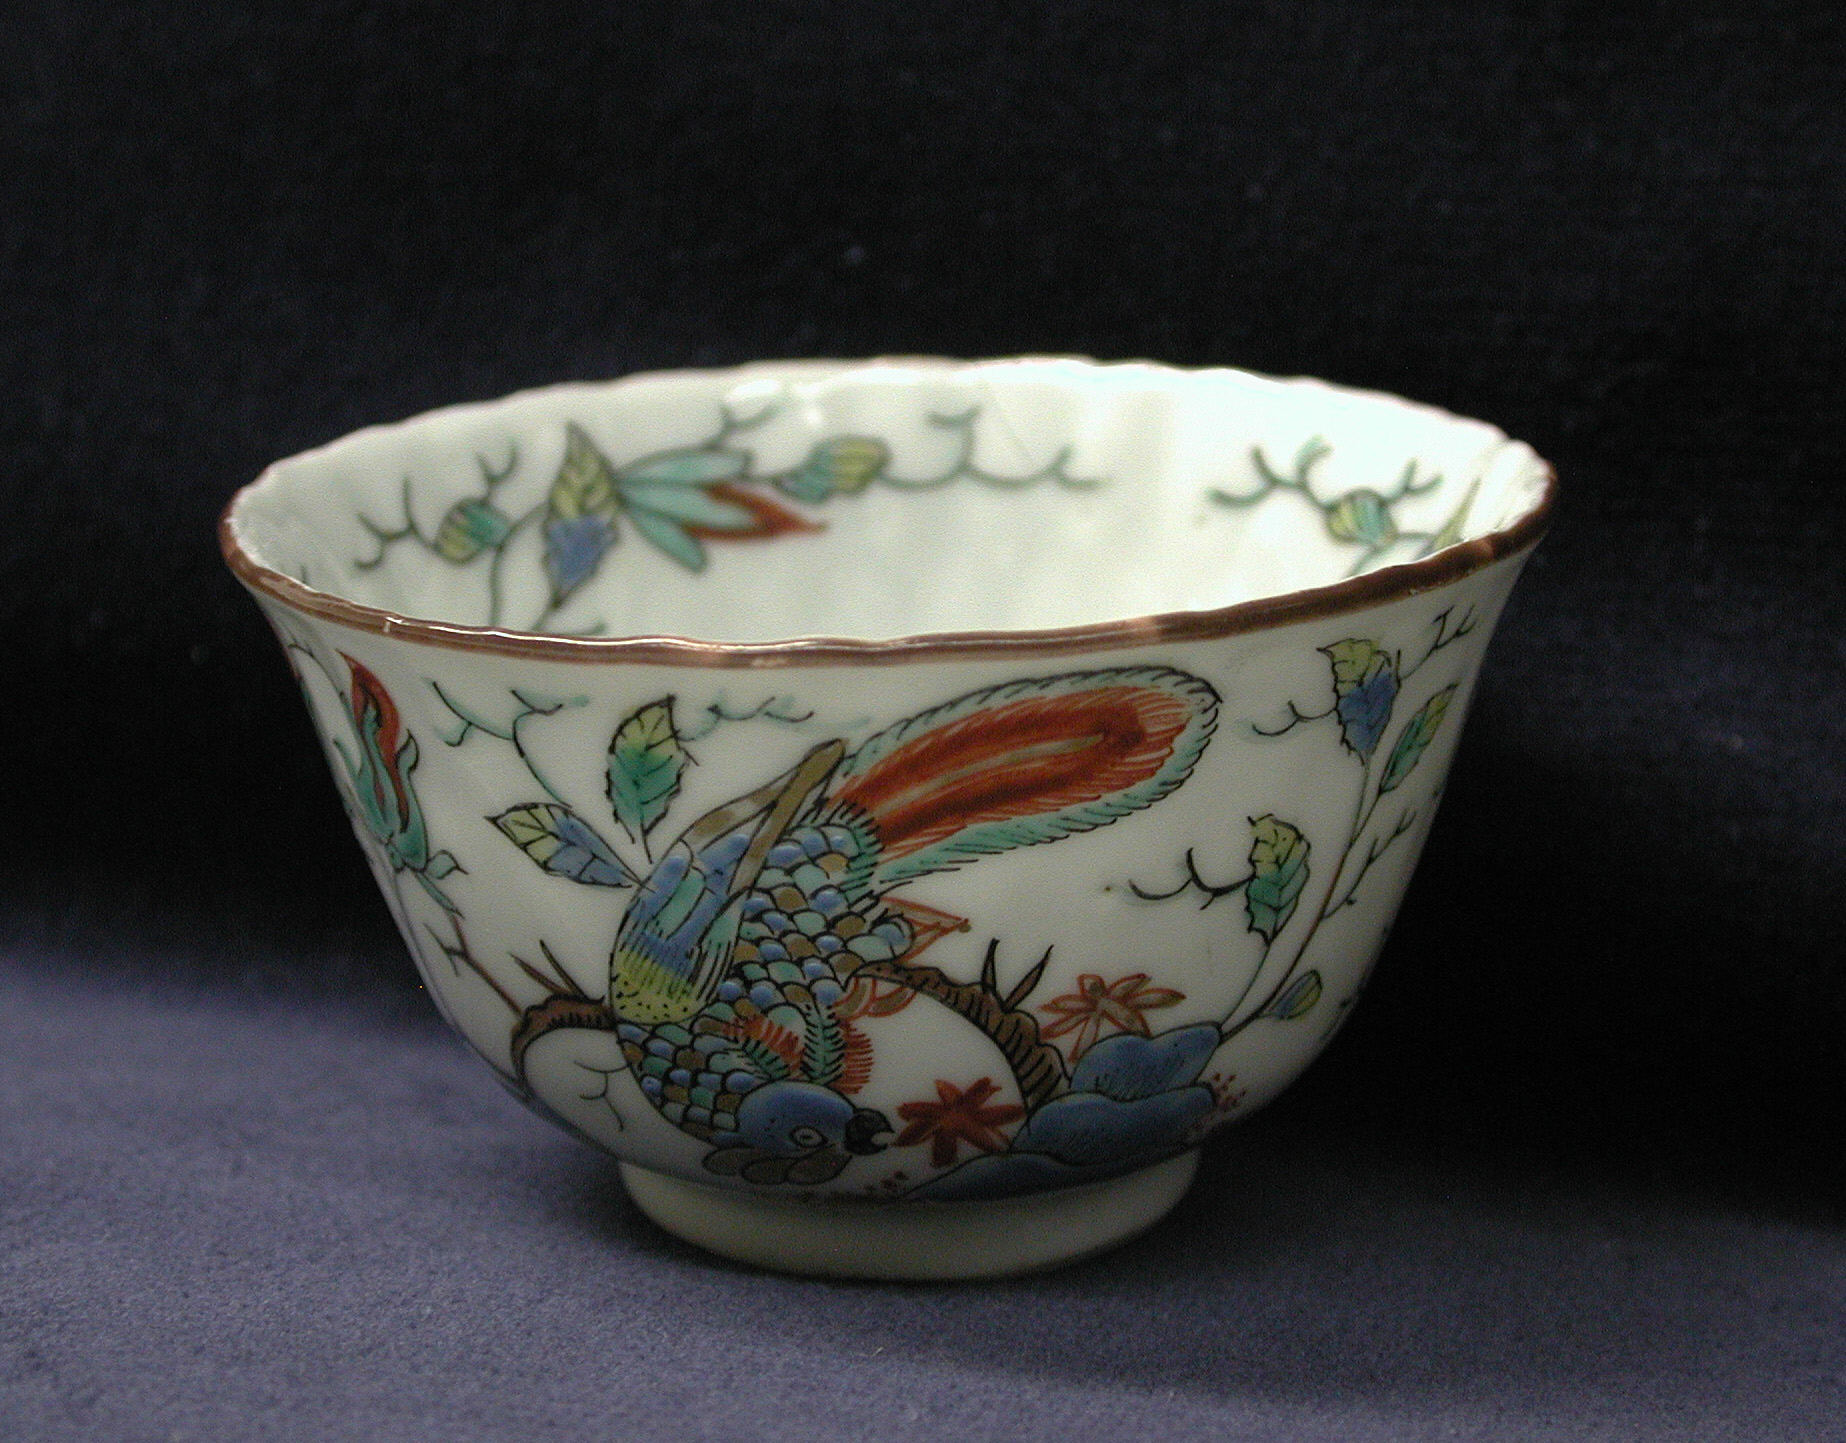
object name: teabowl and saucer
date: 1735-1750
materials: hard paste porcelain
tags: birds